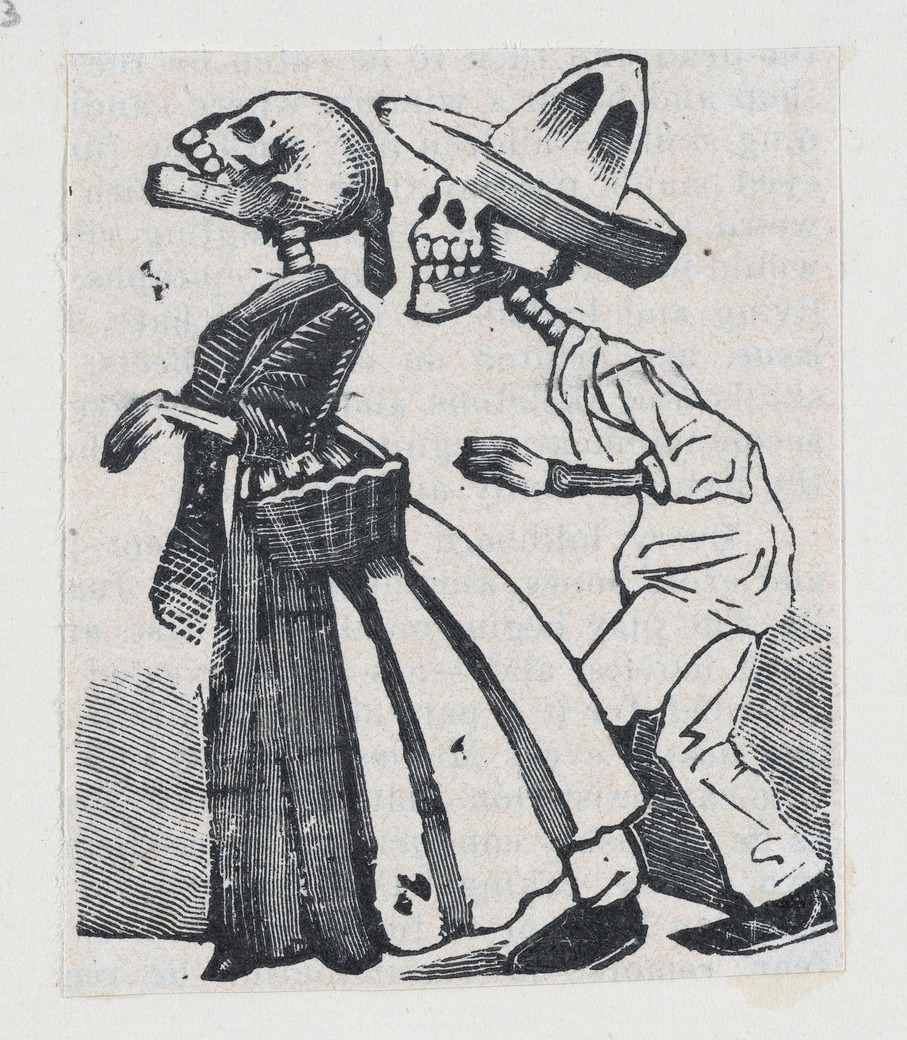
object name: print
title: A male skeleton walking behind a female skeleton (vignette for the feast of the dead)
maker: josé guadalupe posada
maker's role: artist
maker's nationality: mexican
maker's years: 1852-1913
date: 1894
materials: metal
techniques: engraving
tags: skeletons,men,women,walking